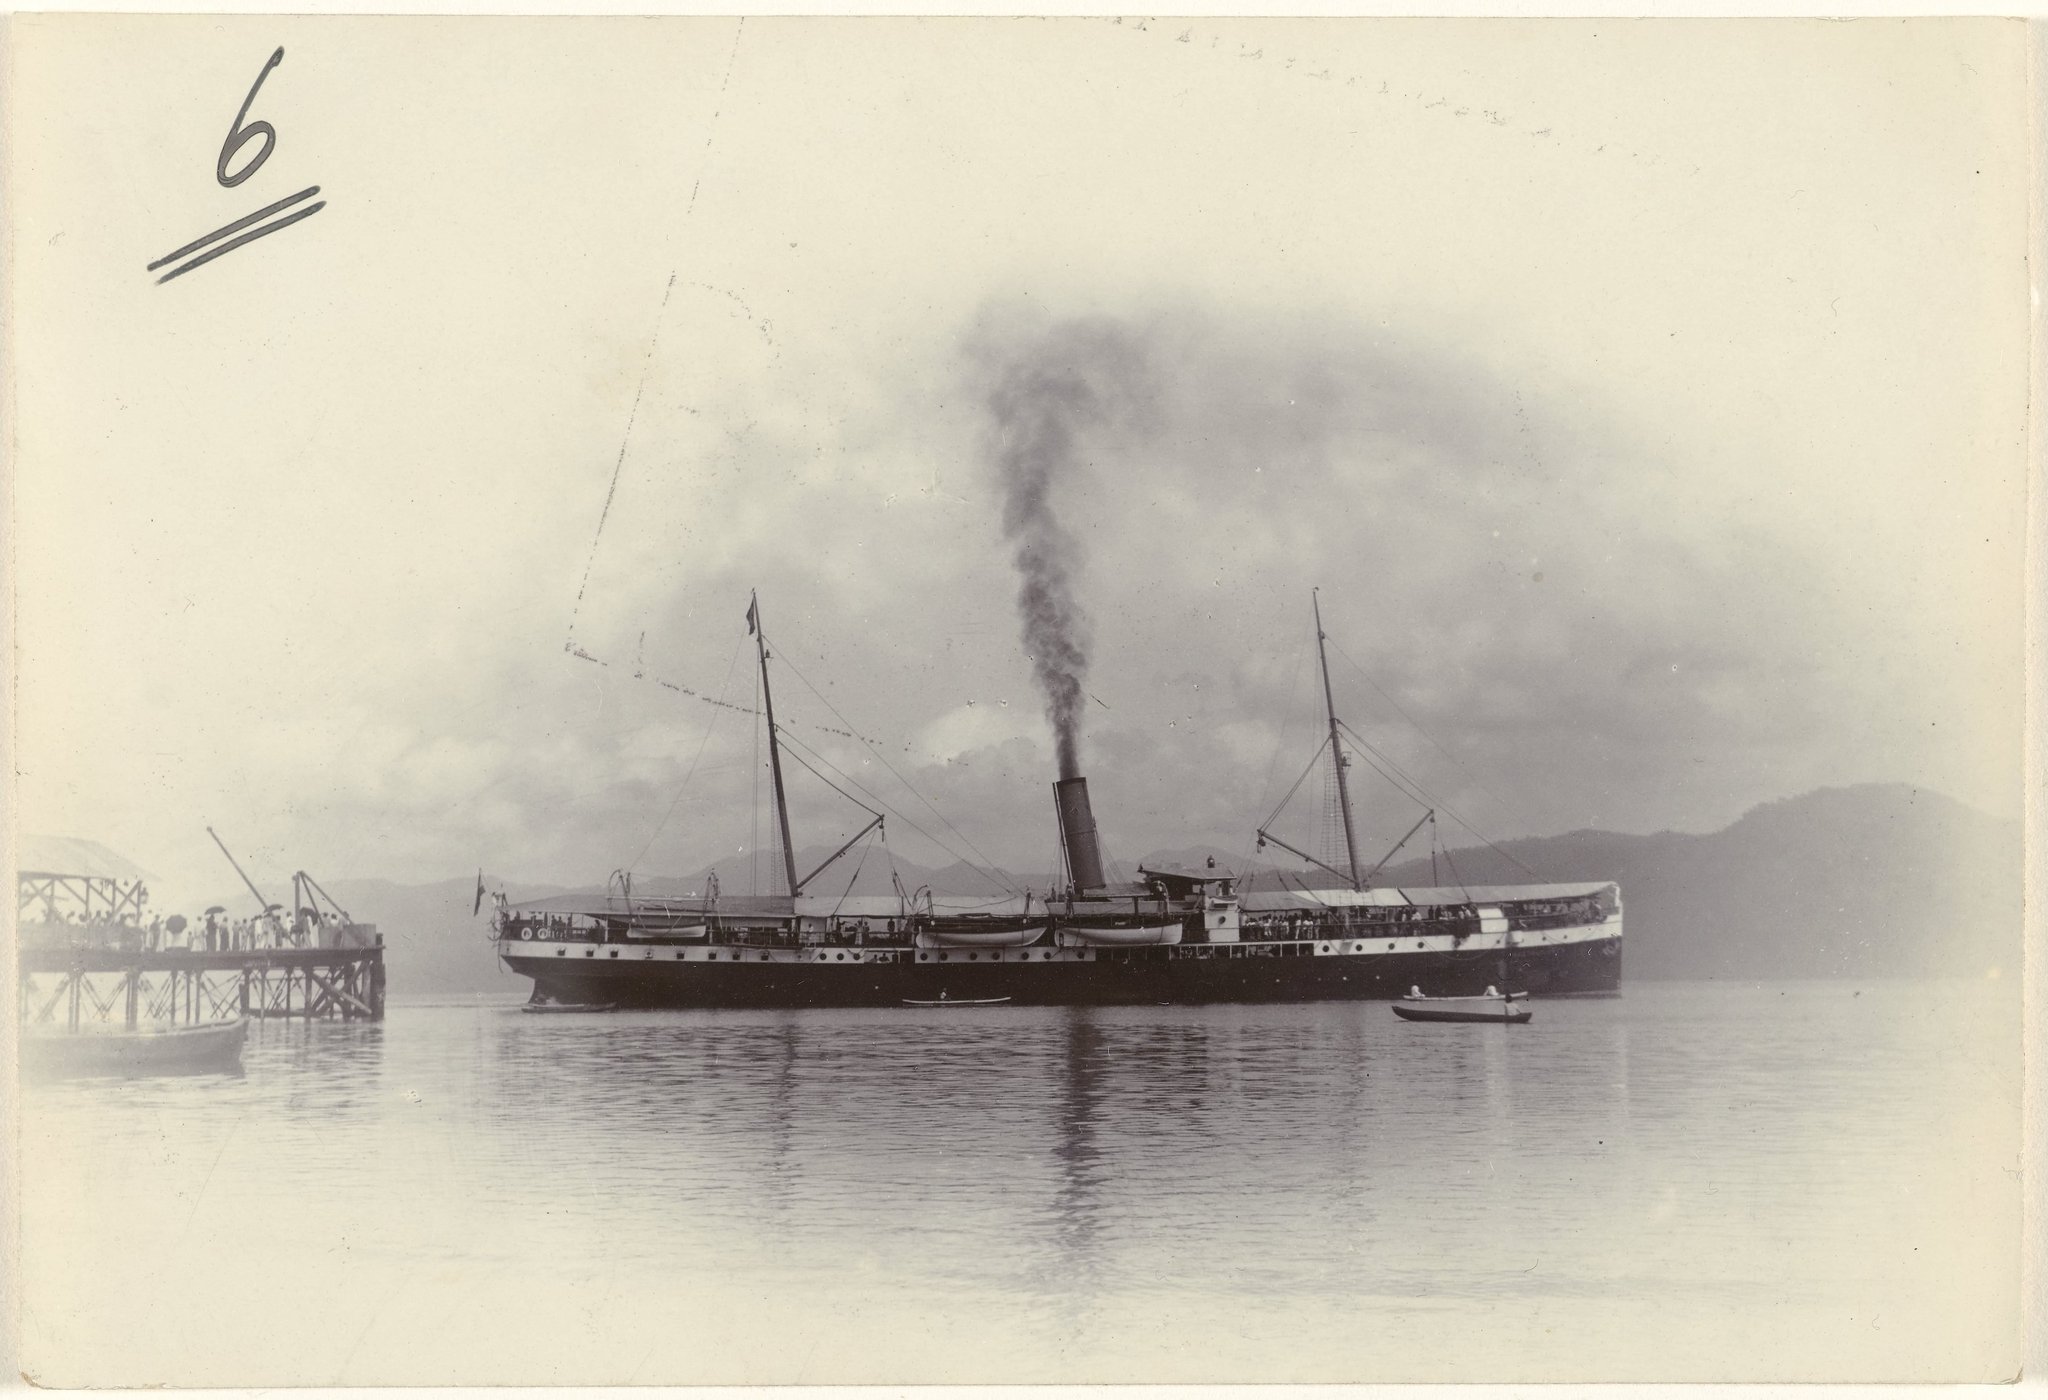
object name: photograph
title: Stoomschip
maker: Anonymous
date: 1885-1910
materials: paper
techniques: gelatin silver print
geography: indonesia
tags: steamship, motorship, indonesia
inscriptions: number: ‘6’